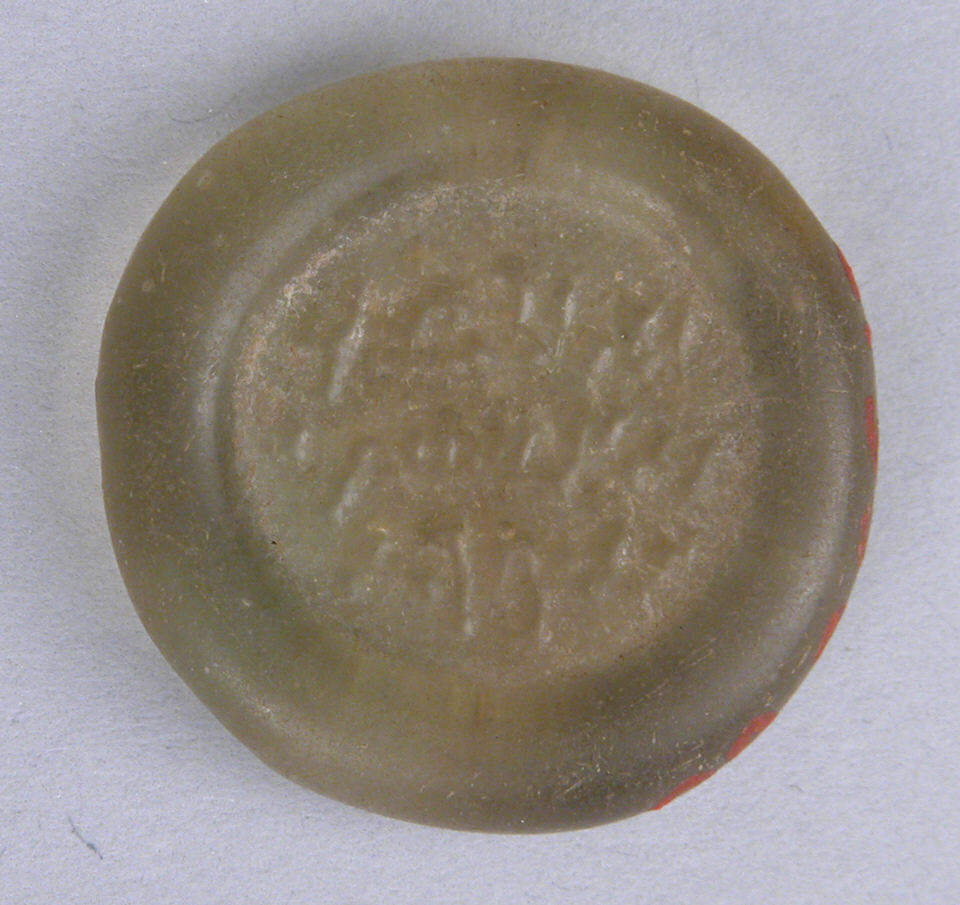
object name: coin weight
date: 1001-1100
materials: glass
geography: egypt